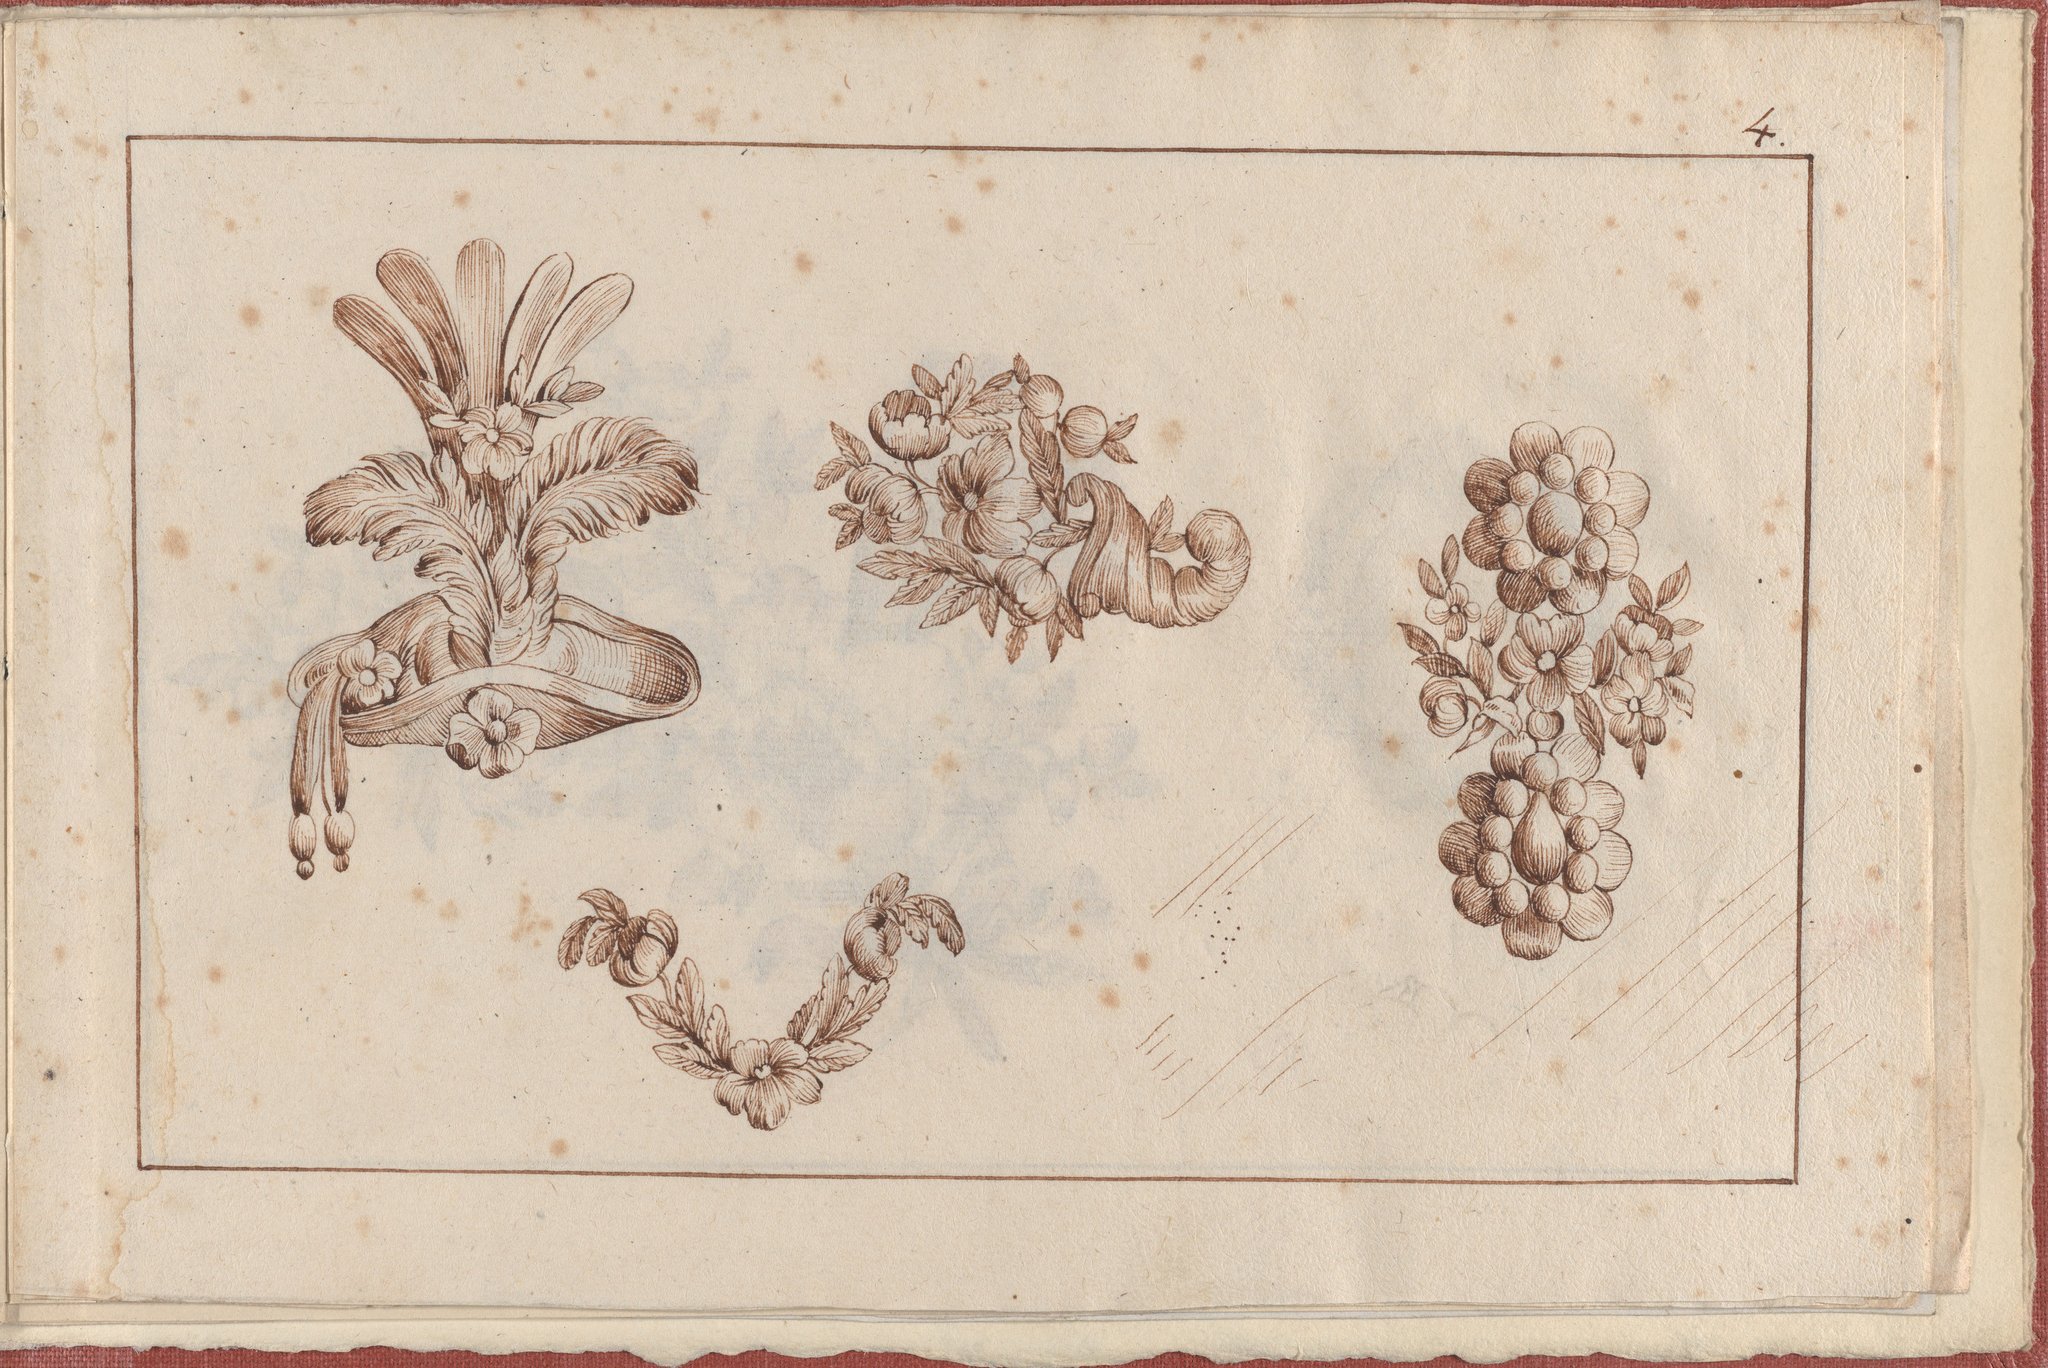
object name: album print ornament architecture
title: Joaillerie: Album of Jewelry Designs, Page 4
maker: anonymous, french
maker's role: artist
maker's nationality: french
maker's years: 1400-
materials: ink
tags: jewelry